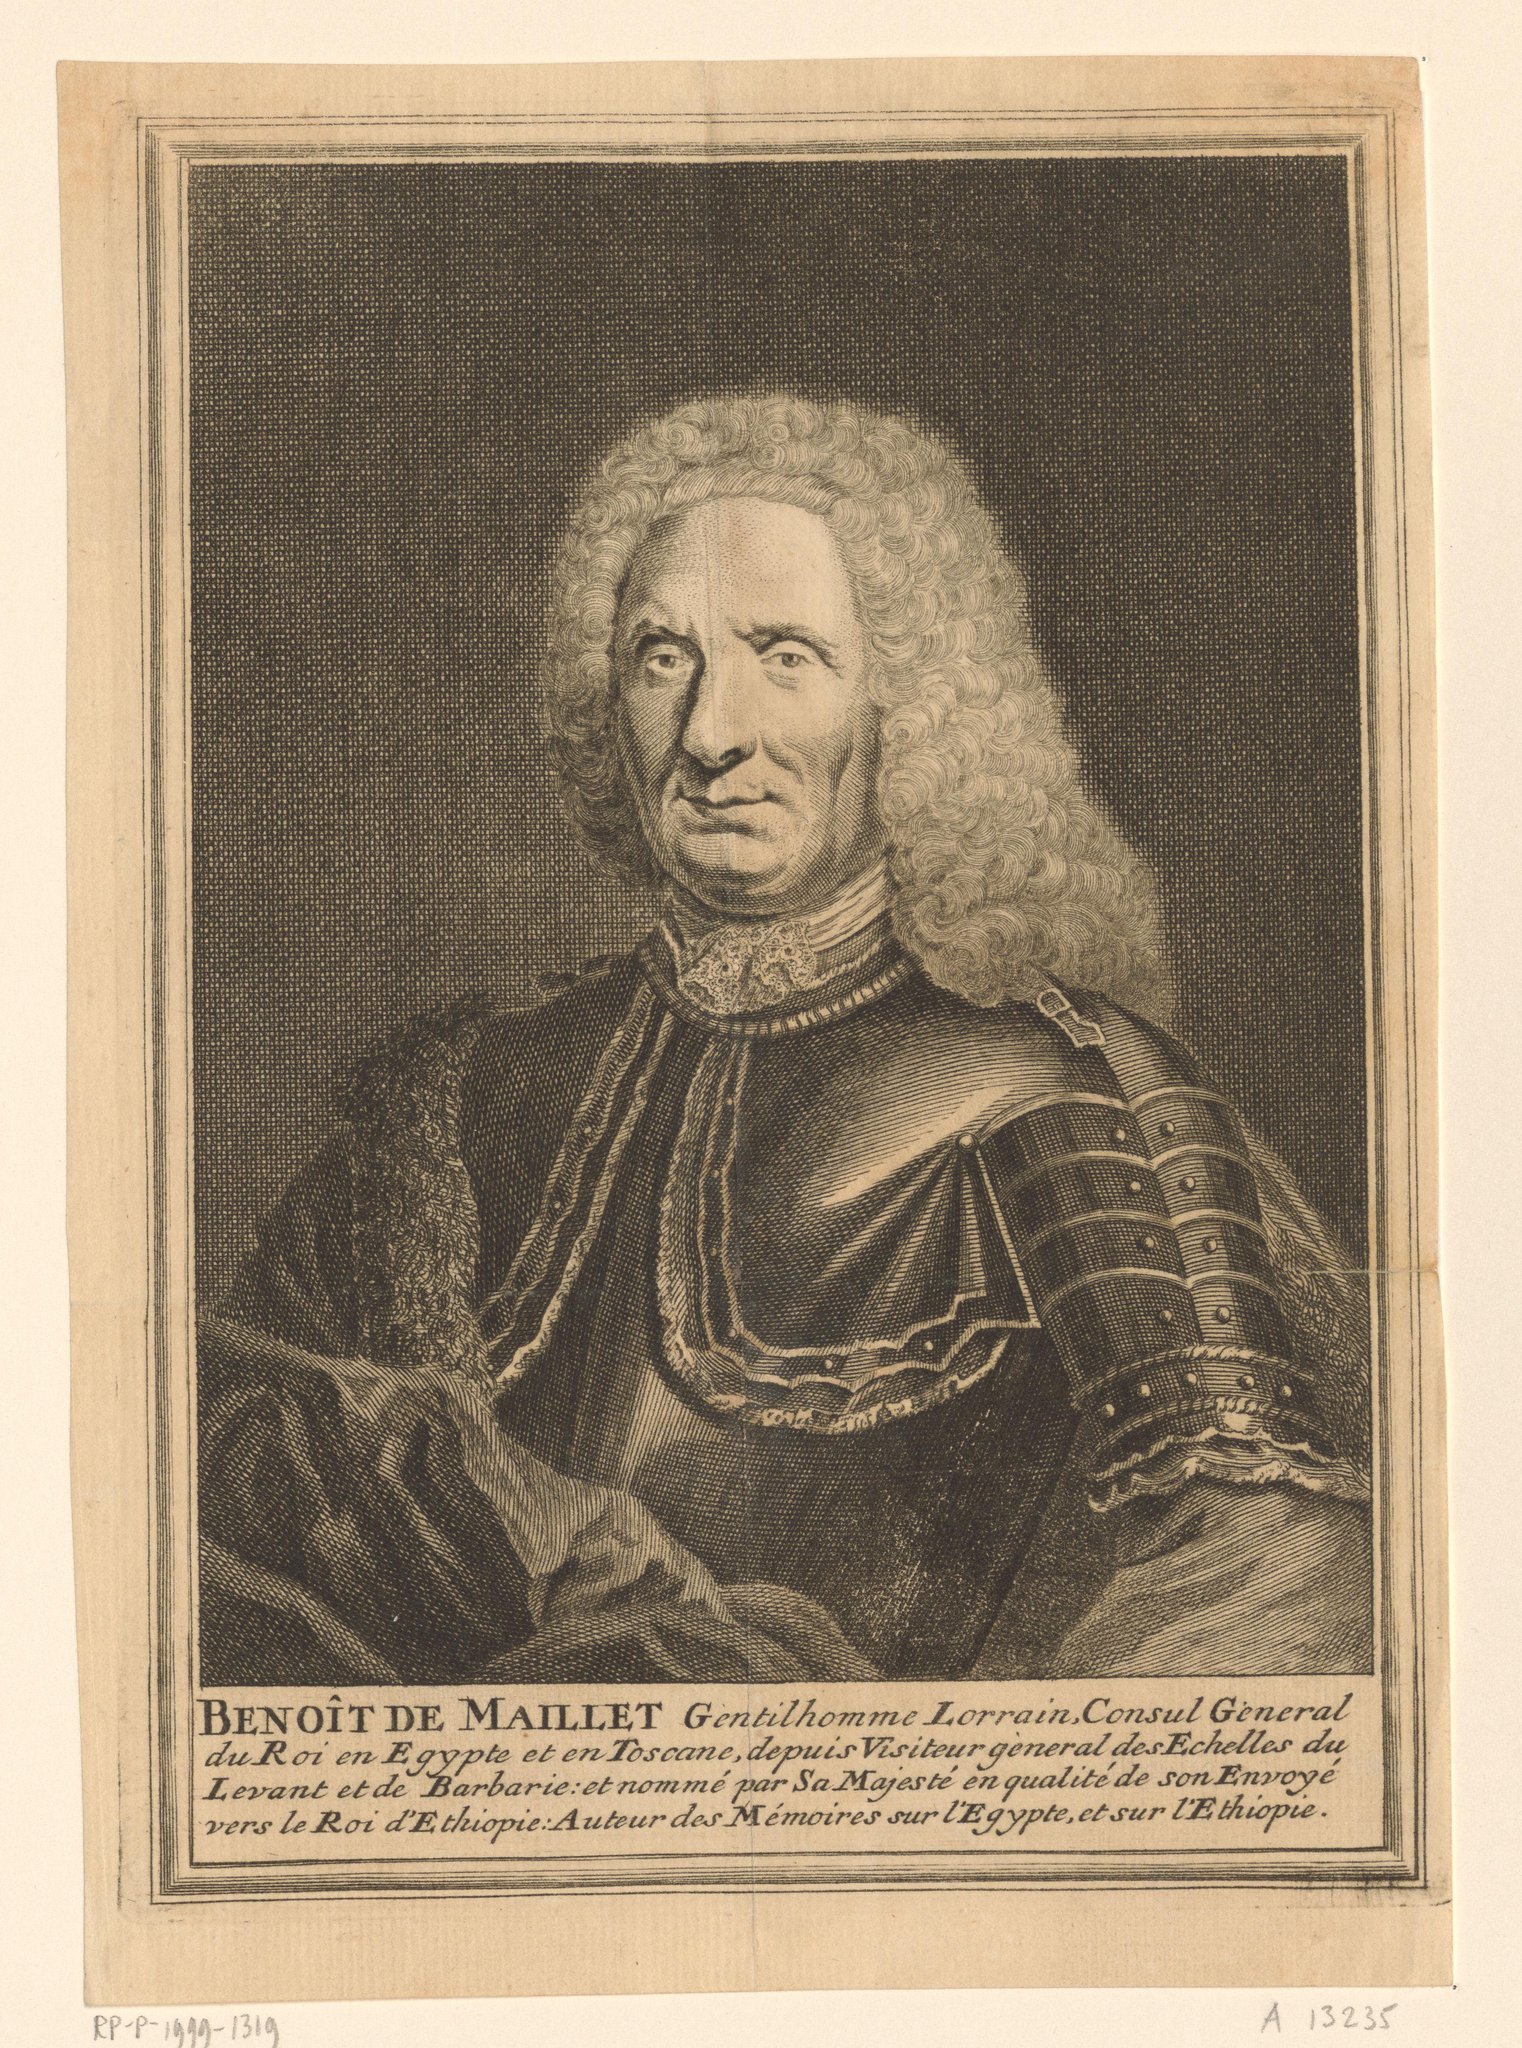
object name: print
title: Portret van Benoît de Maillet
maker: Anonymous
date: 1666-1736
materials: paper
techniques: engraving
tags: marseille, historical persons, diplomacy, diplomat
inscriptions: collector's mark: Lugt 2760, collector's mark: Lugt 2228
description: Benoît de Maillet was een Frans antropoloog en bereisd diplomaat. Onderschrift in het Frans.